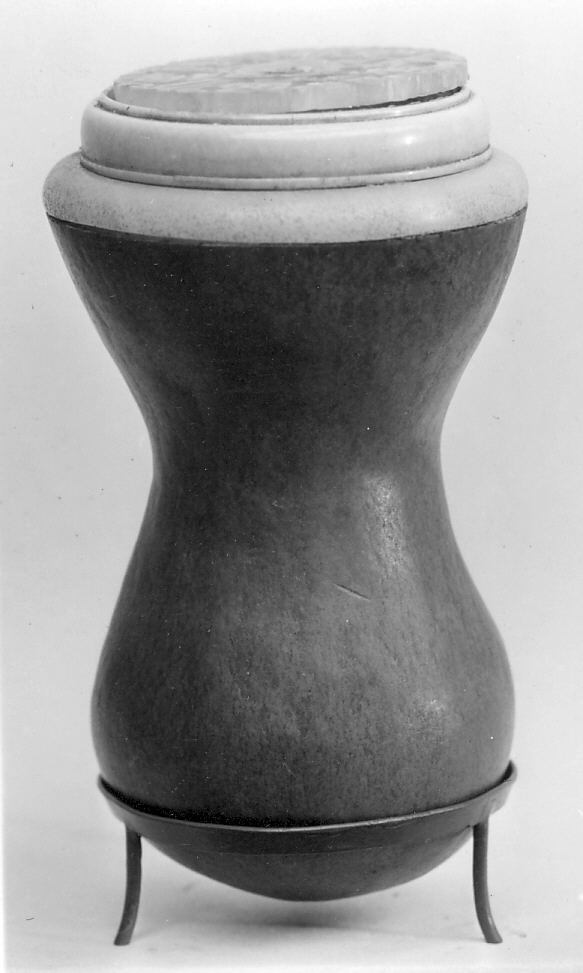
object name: cricket cage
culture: chinese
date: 1701-1900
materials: jade